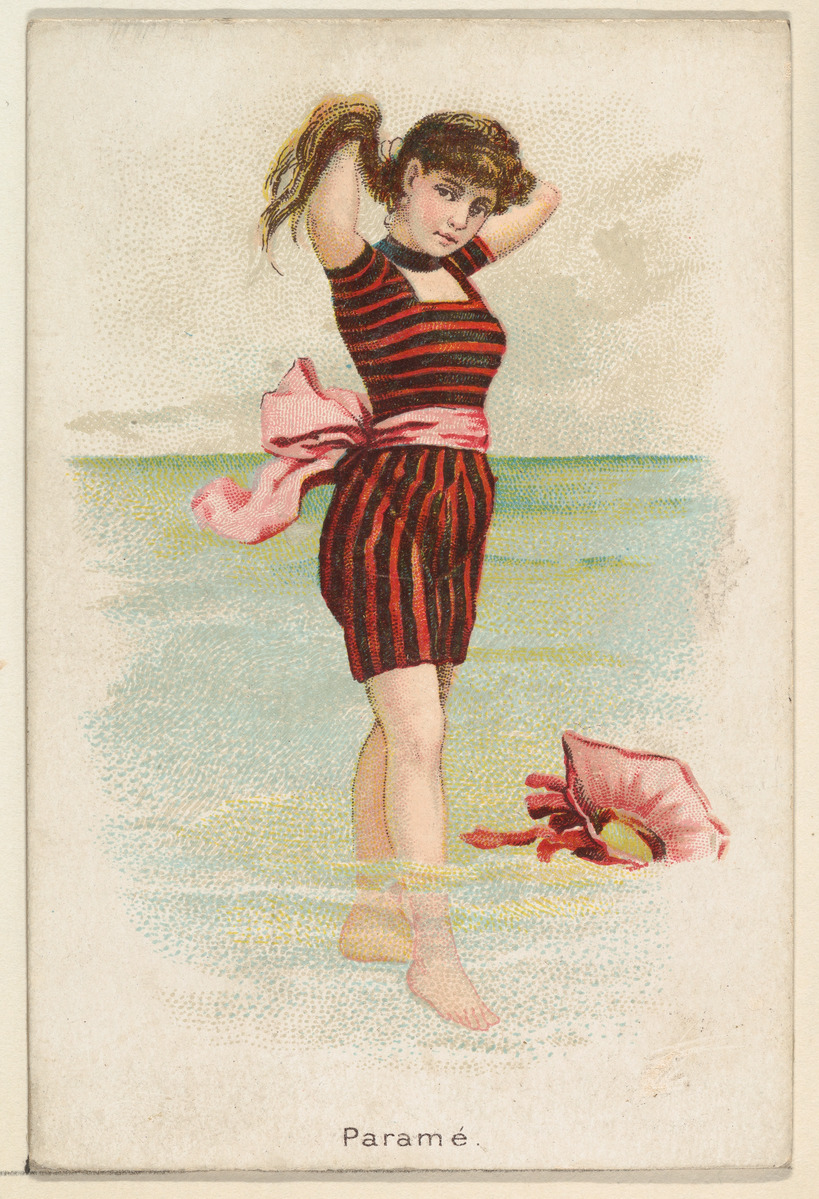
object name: print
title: Parame, from the Beautiful Bathers series (N192) issued by Wm. S. Kimball & Co.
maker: william s. kimball & company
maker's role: publisher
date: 1889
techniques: color lithograph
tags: women